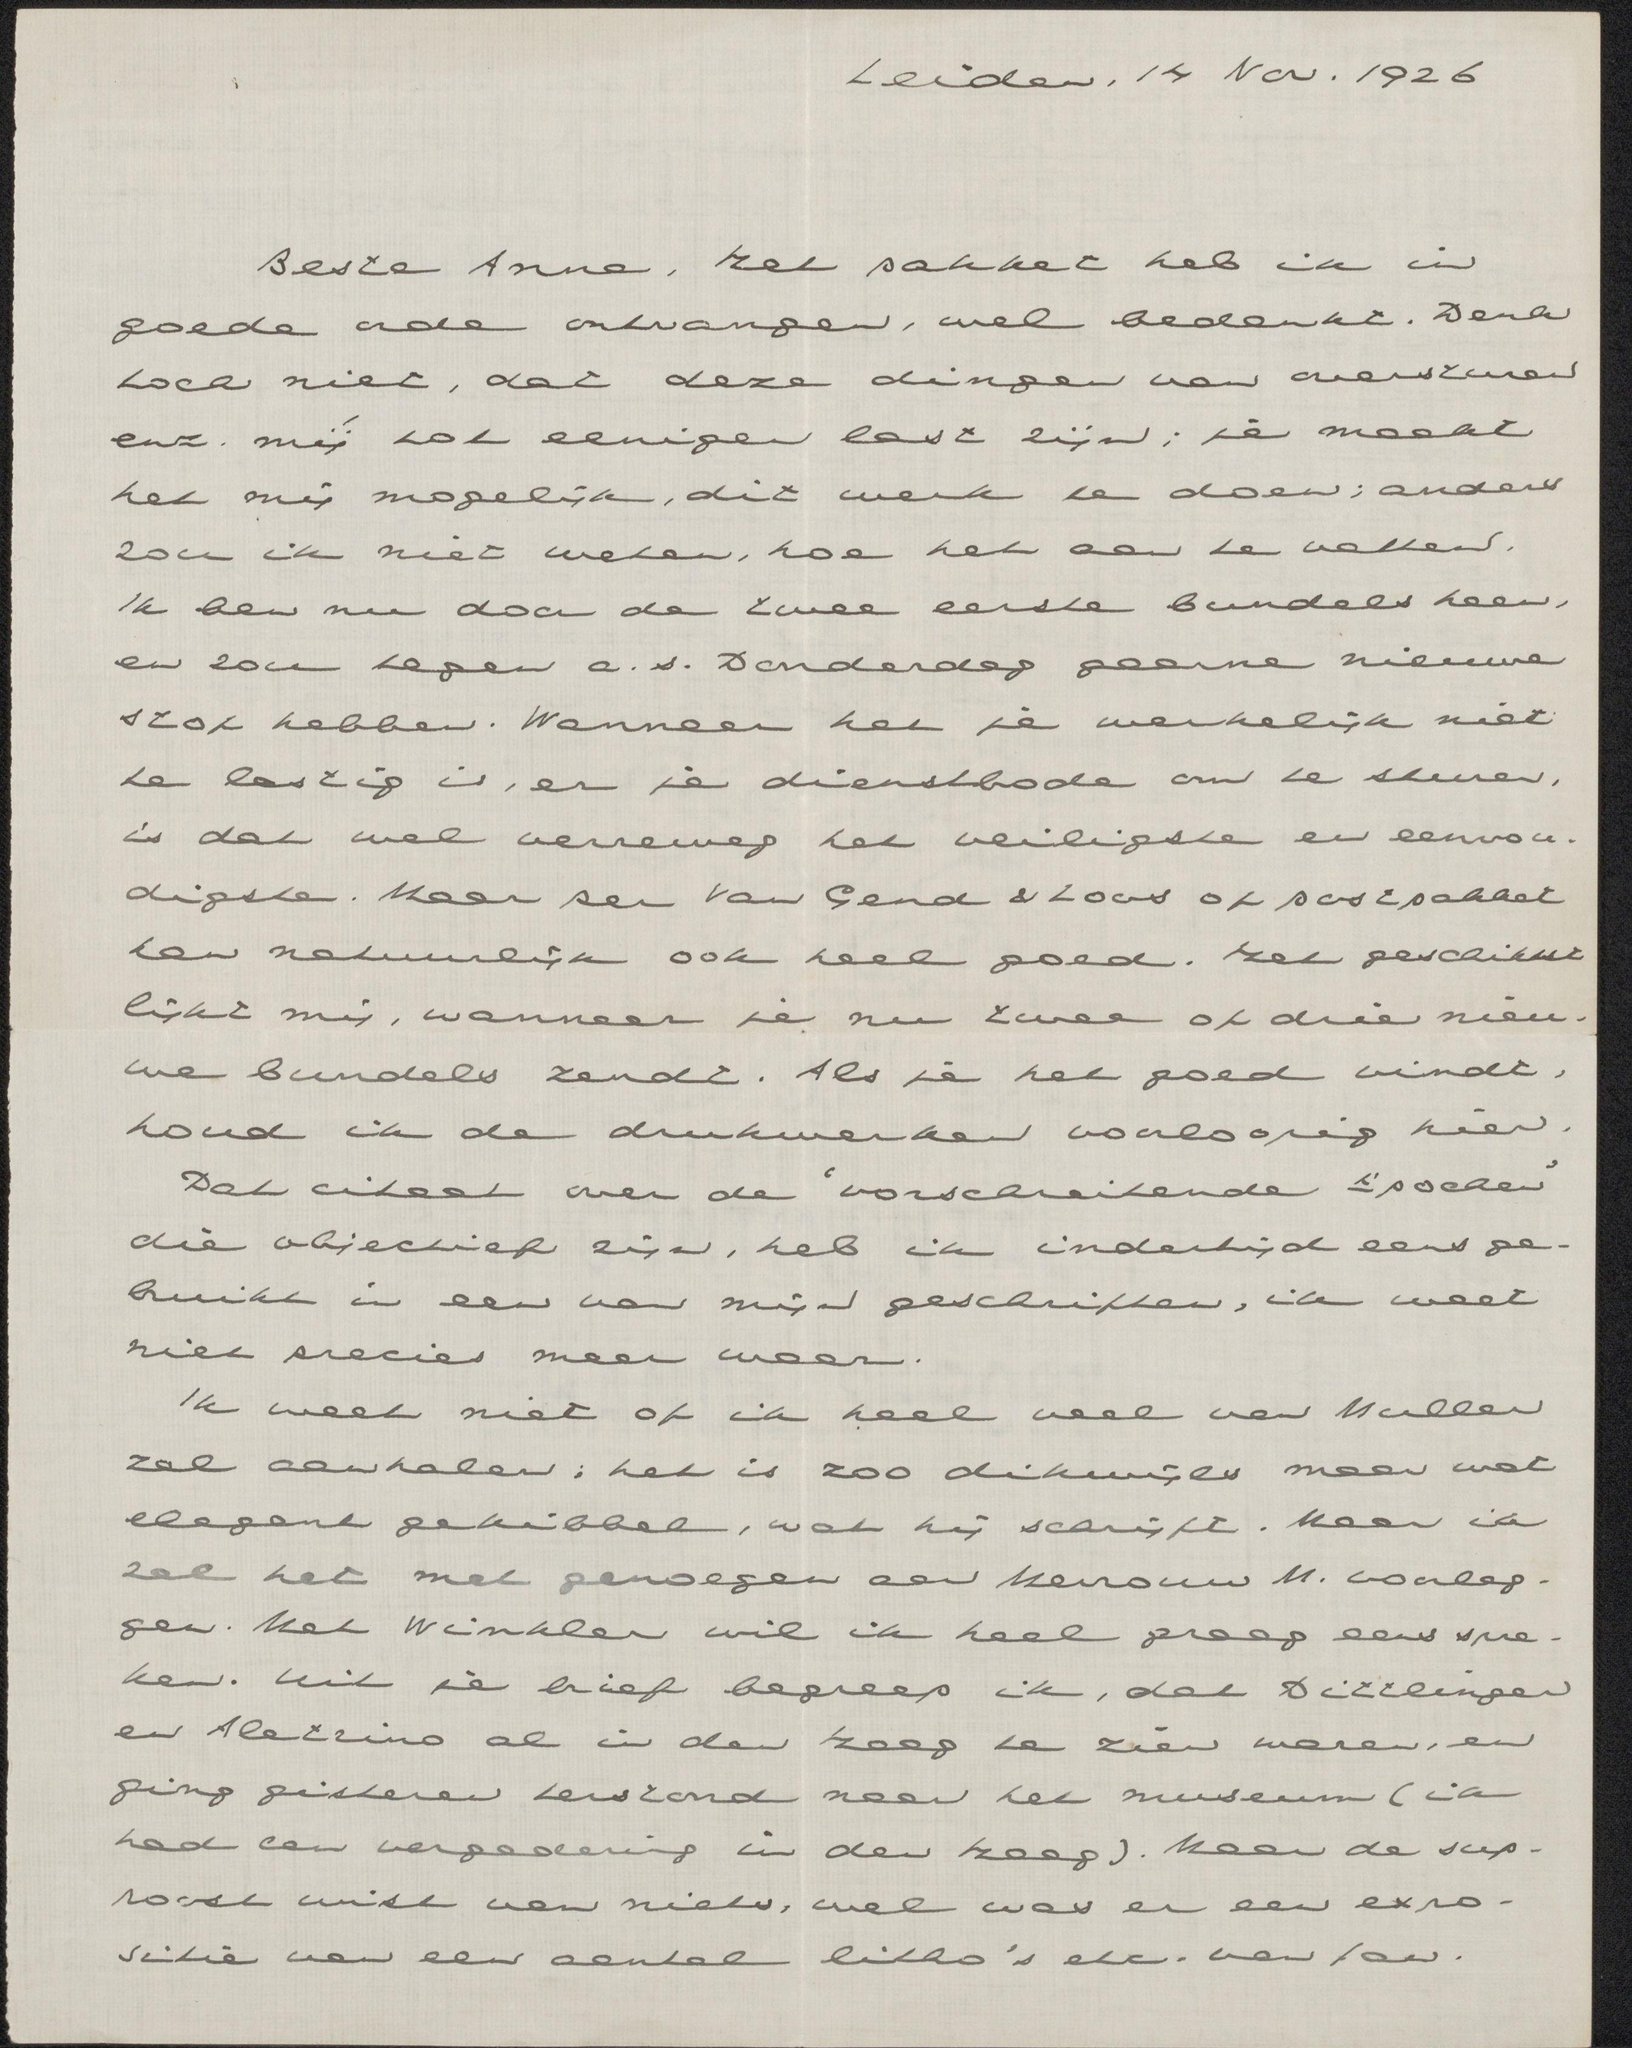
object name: letter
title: Brief aan Anna Dorothea Dirks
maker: johan huizinga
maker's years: 1872-1945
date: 1926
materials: ink, paper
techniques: pen, writing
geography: leiden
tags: samuel muller (1848-1922), artist, anna dorothea dirks, amsterdam, cornelis winkler, painter, painting (including book-illumination, miniature-painting), exhibition ~ art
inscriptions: watermark, collector's mark: ‘RPK’